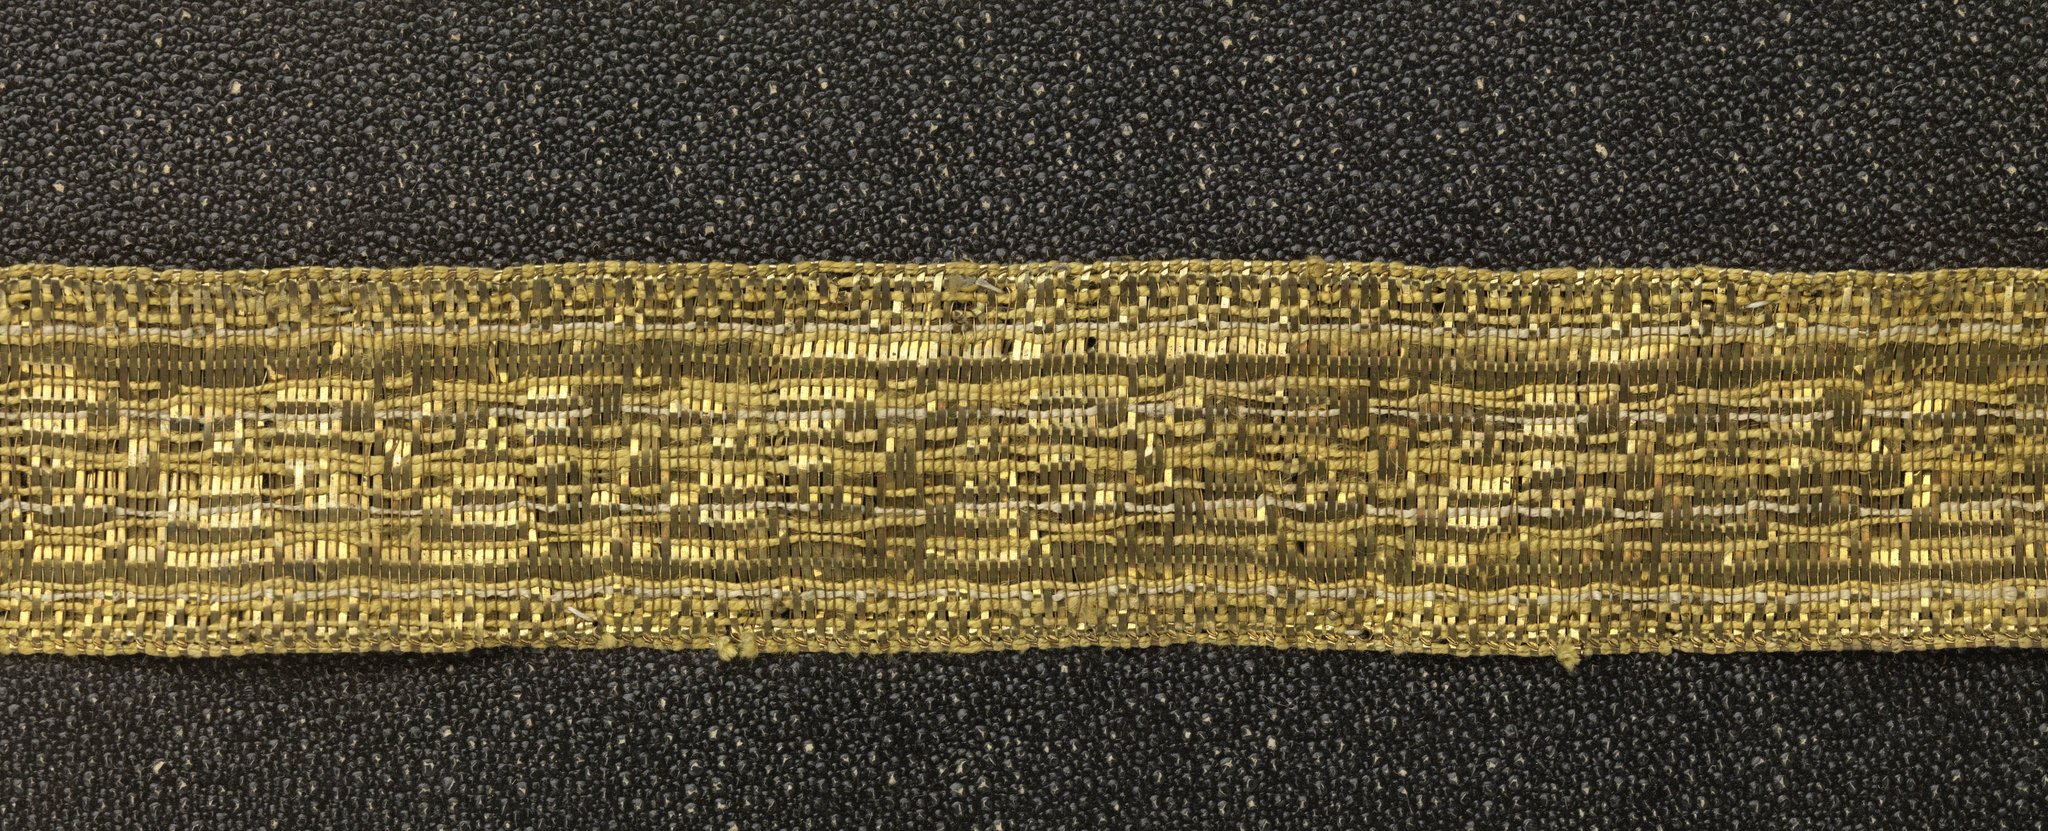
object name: braid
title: Strook passement met gouddraad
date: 1800-1900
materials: gold thread